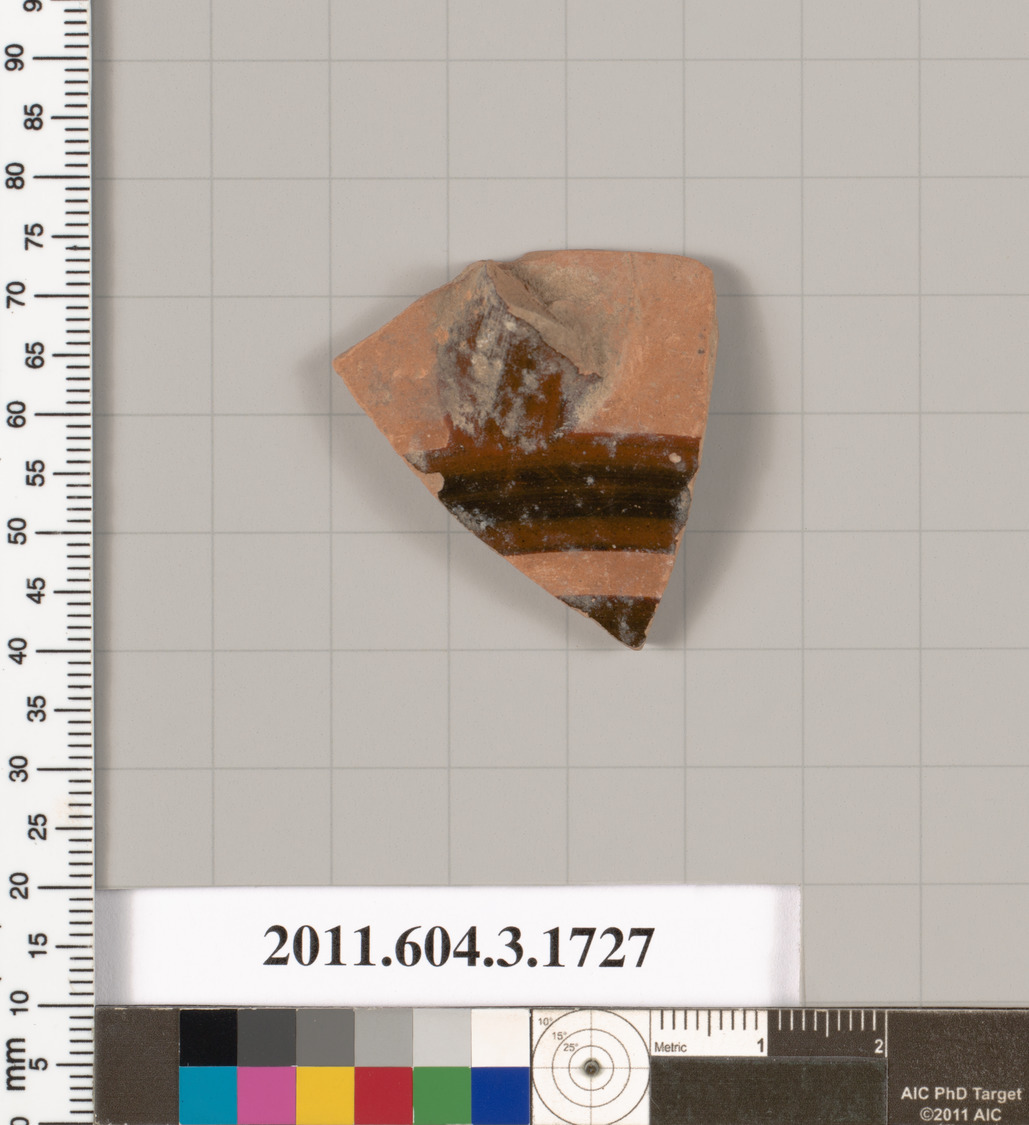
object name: kylix fragment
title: Terracotta fragment of a kylix: Band or lip cup (drinking cup)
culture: greek, attic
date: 550-526 BCE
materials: terracotta